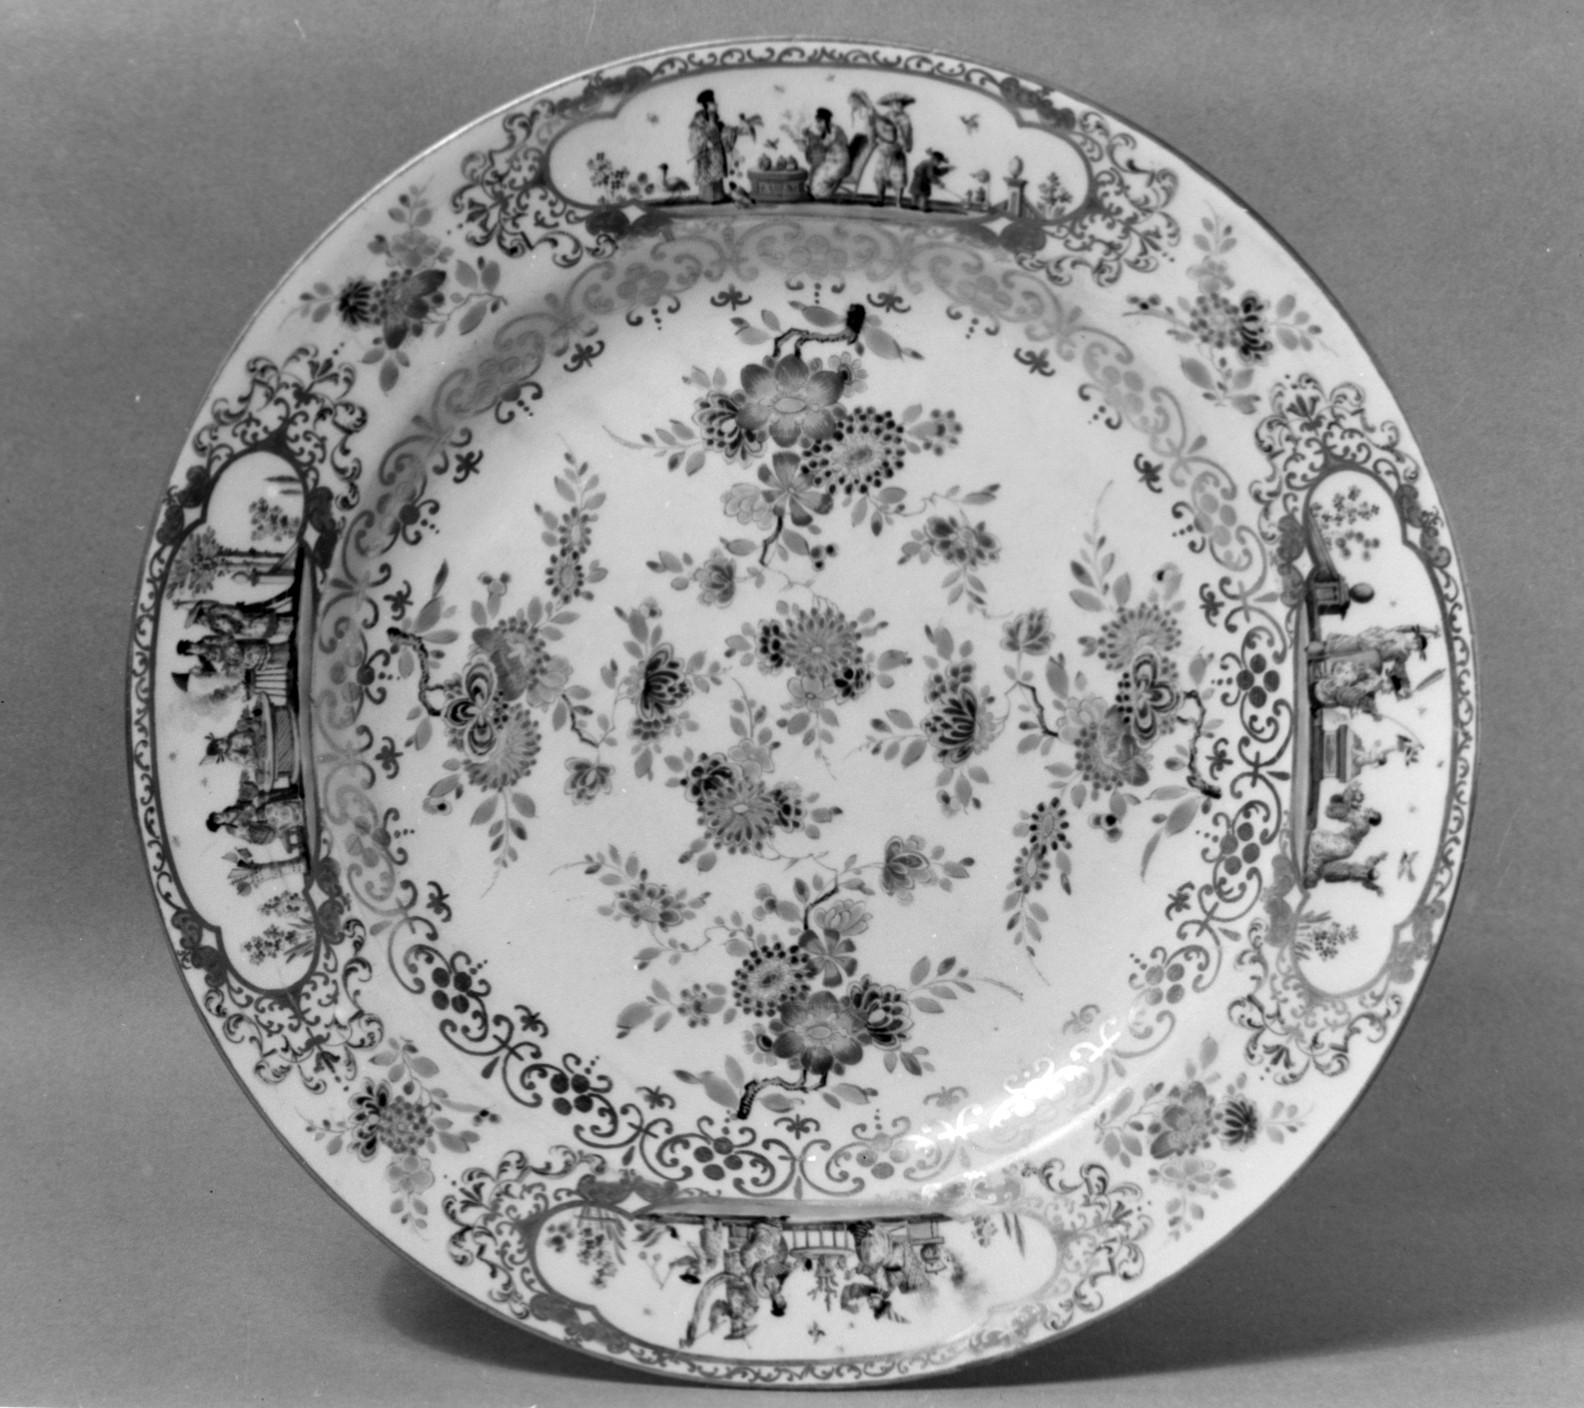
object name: plate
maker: meissen manufactory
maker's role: manufactory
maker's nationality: german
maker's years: 1710-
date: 1725-1730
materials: hard paste porcelain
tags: human figures,flowers